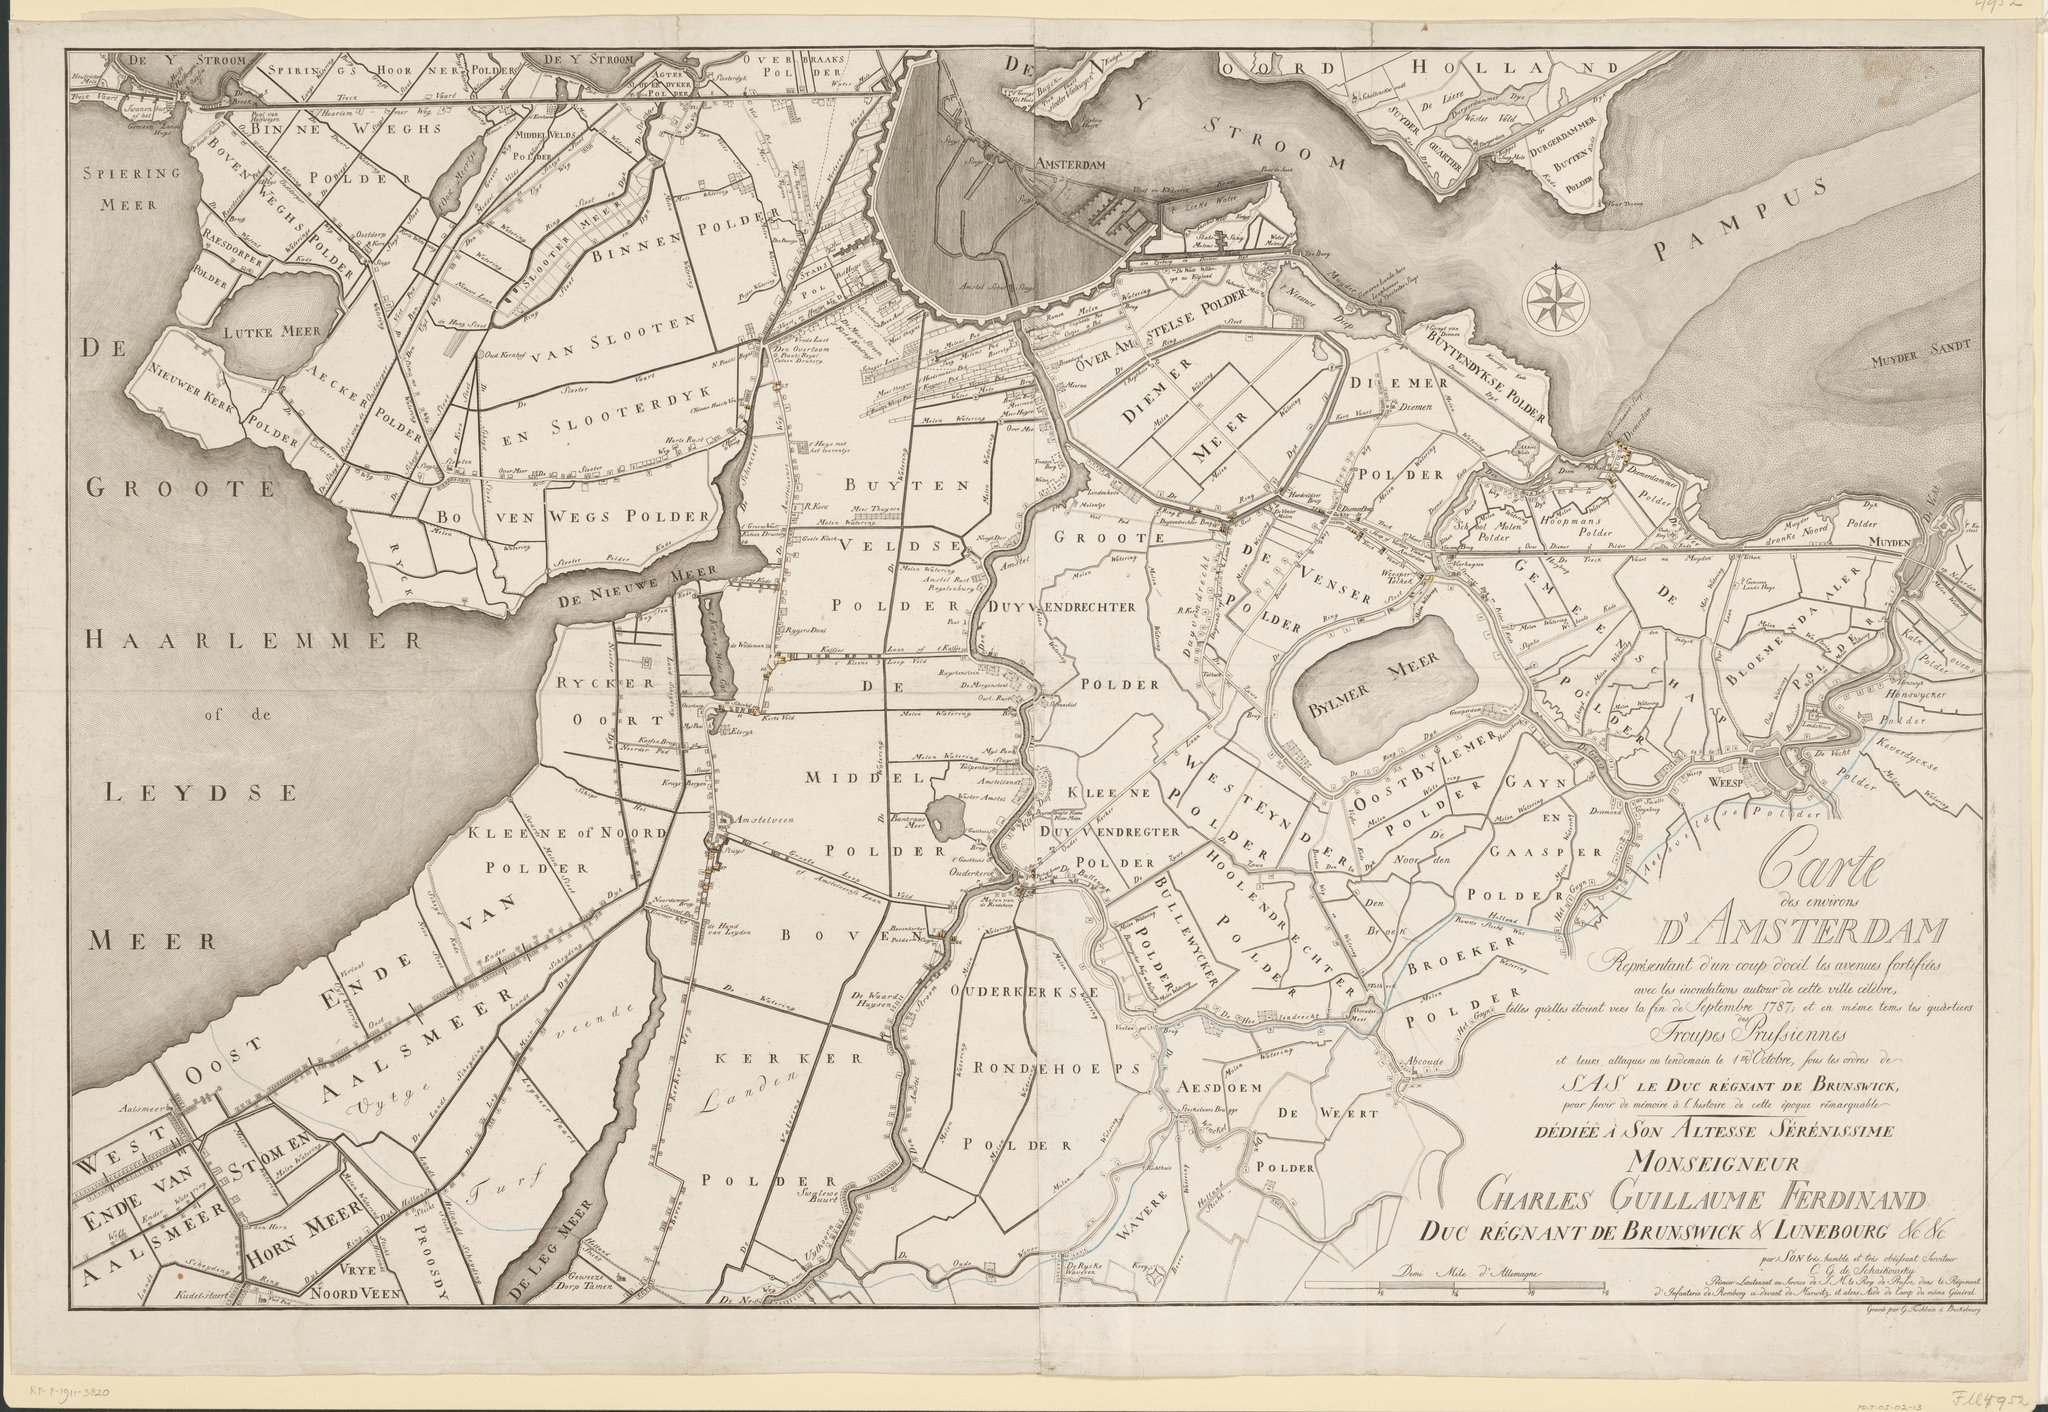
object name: map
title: Kaart van Amsterdam en de posities van de Pruisische troepen rondom de stad, 1787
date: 1788-1789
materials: paper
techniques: etching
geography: bückeburg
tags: karel willem ferdinand hertog van brunswijk-wolfenbüttel, dike-break, maps of separate countries or regions, amsterdam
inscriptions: collector's mark: Lugt 2228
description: Kaart van Amsterdam en omstreken waarop zijn aangegeven de posities van de Pruisische troepen en het gebied dat onder water is gezet bij het naderen van de Pruisische troepen onder de hertog van Brunswijk, eind september - 1 oktober 1787. Een blauw gekleurde stippellijn geeft de omtrek van de inundatie aan.